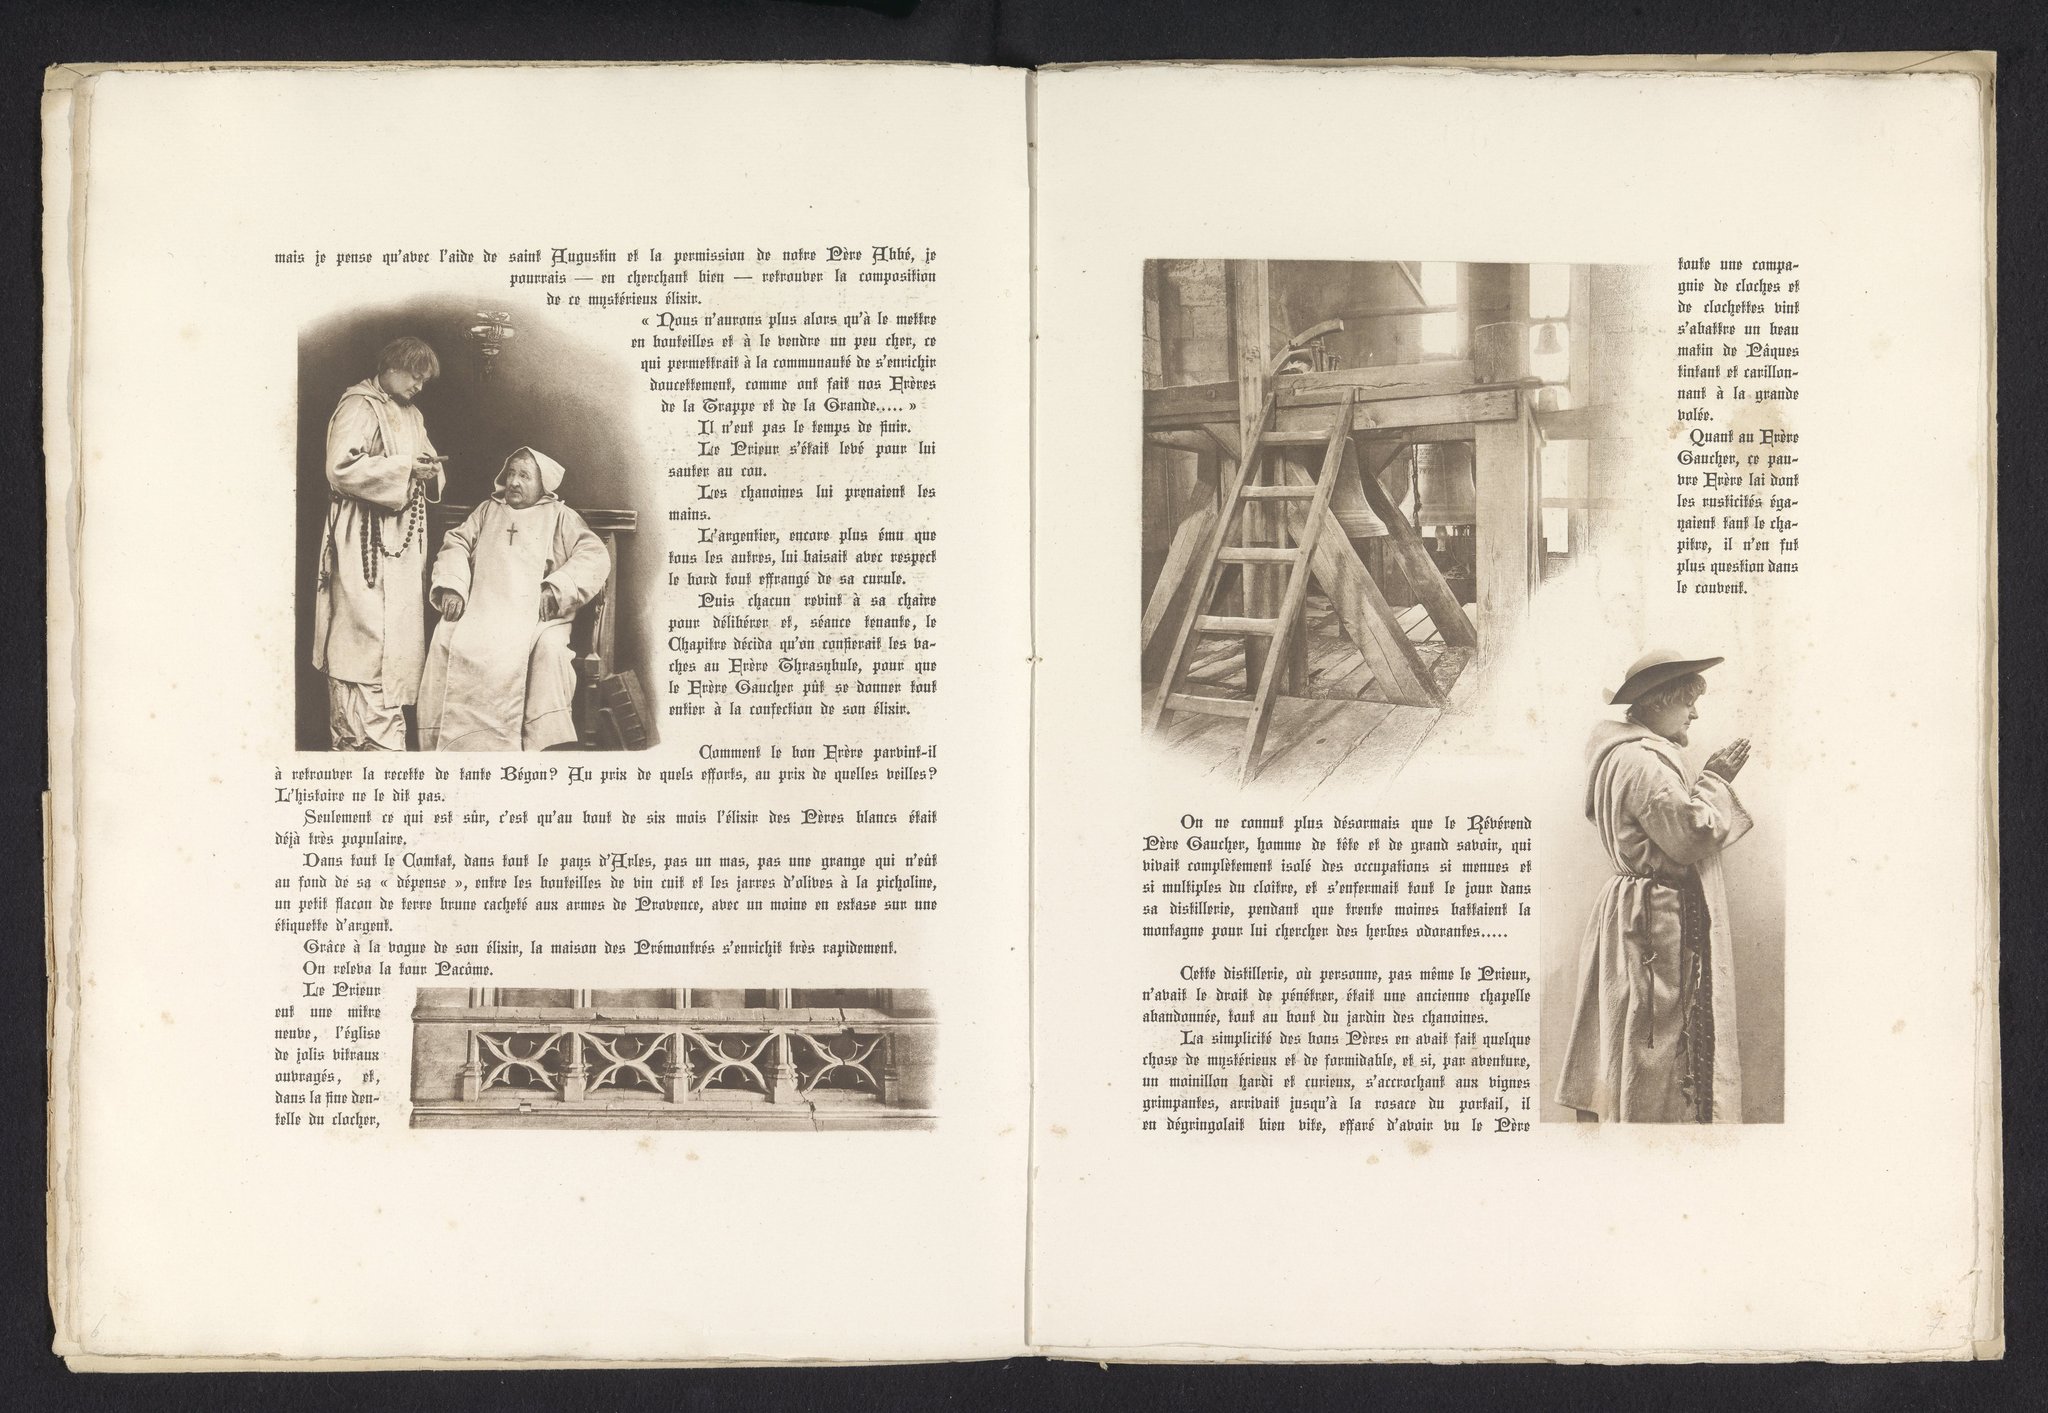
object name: photomechanical print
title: Kerkklok en een biddende monnik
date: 1885-1896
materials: paper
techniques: photoaquatint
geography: france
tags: monk(s), friar(s), interior of church, church bell, one person praying